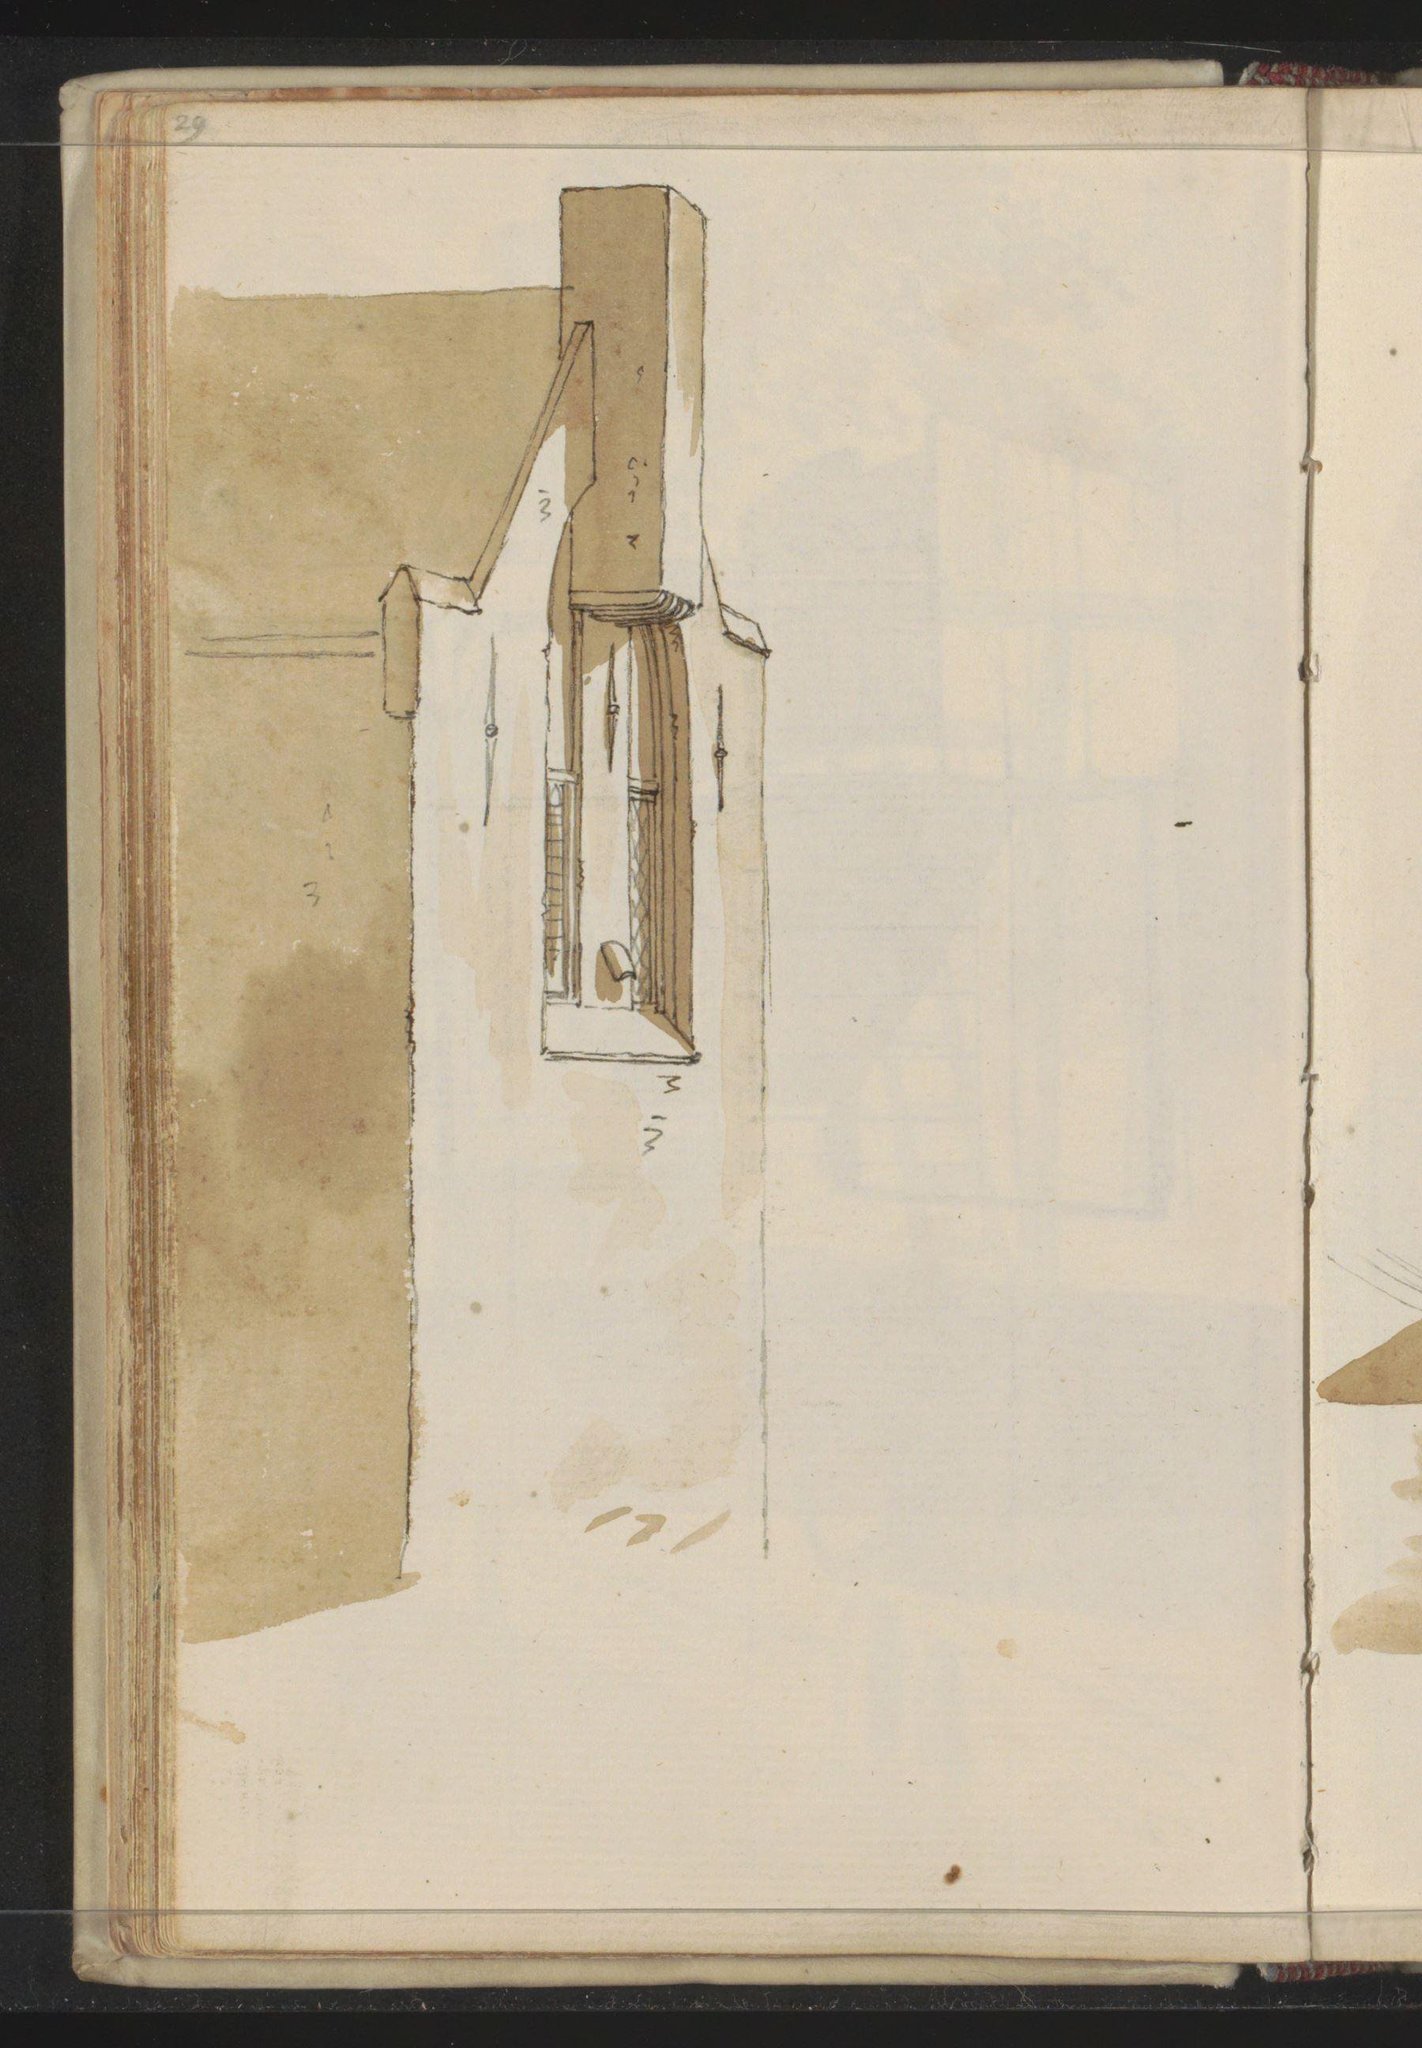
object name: sketchbook leaf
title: Zijaanzicht van een huis met een schoorsteen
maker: johannes huibert prins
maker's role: draughtsman, painter, print maker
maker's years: 1757-1806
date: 1783-1797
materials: ink, paper, pencil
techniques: brush, pen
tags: chimney, exterior ~ representation of a building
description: Pagina 29 uit een schetsboek met 175 pagina's.